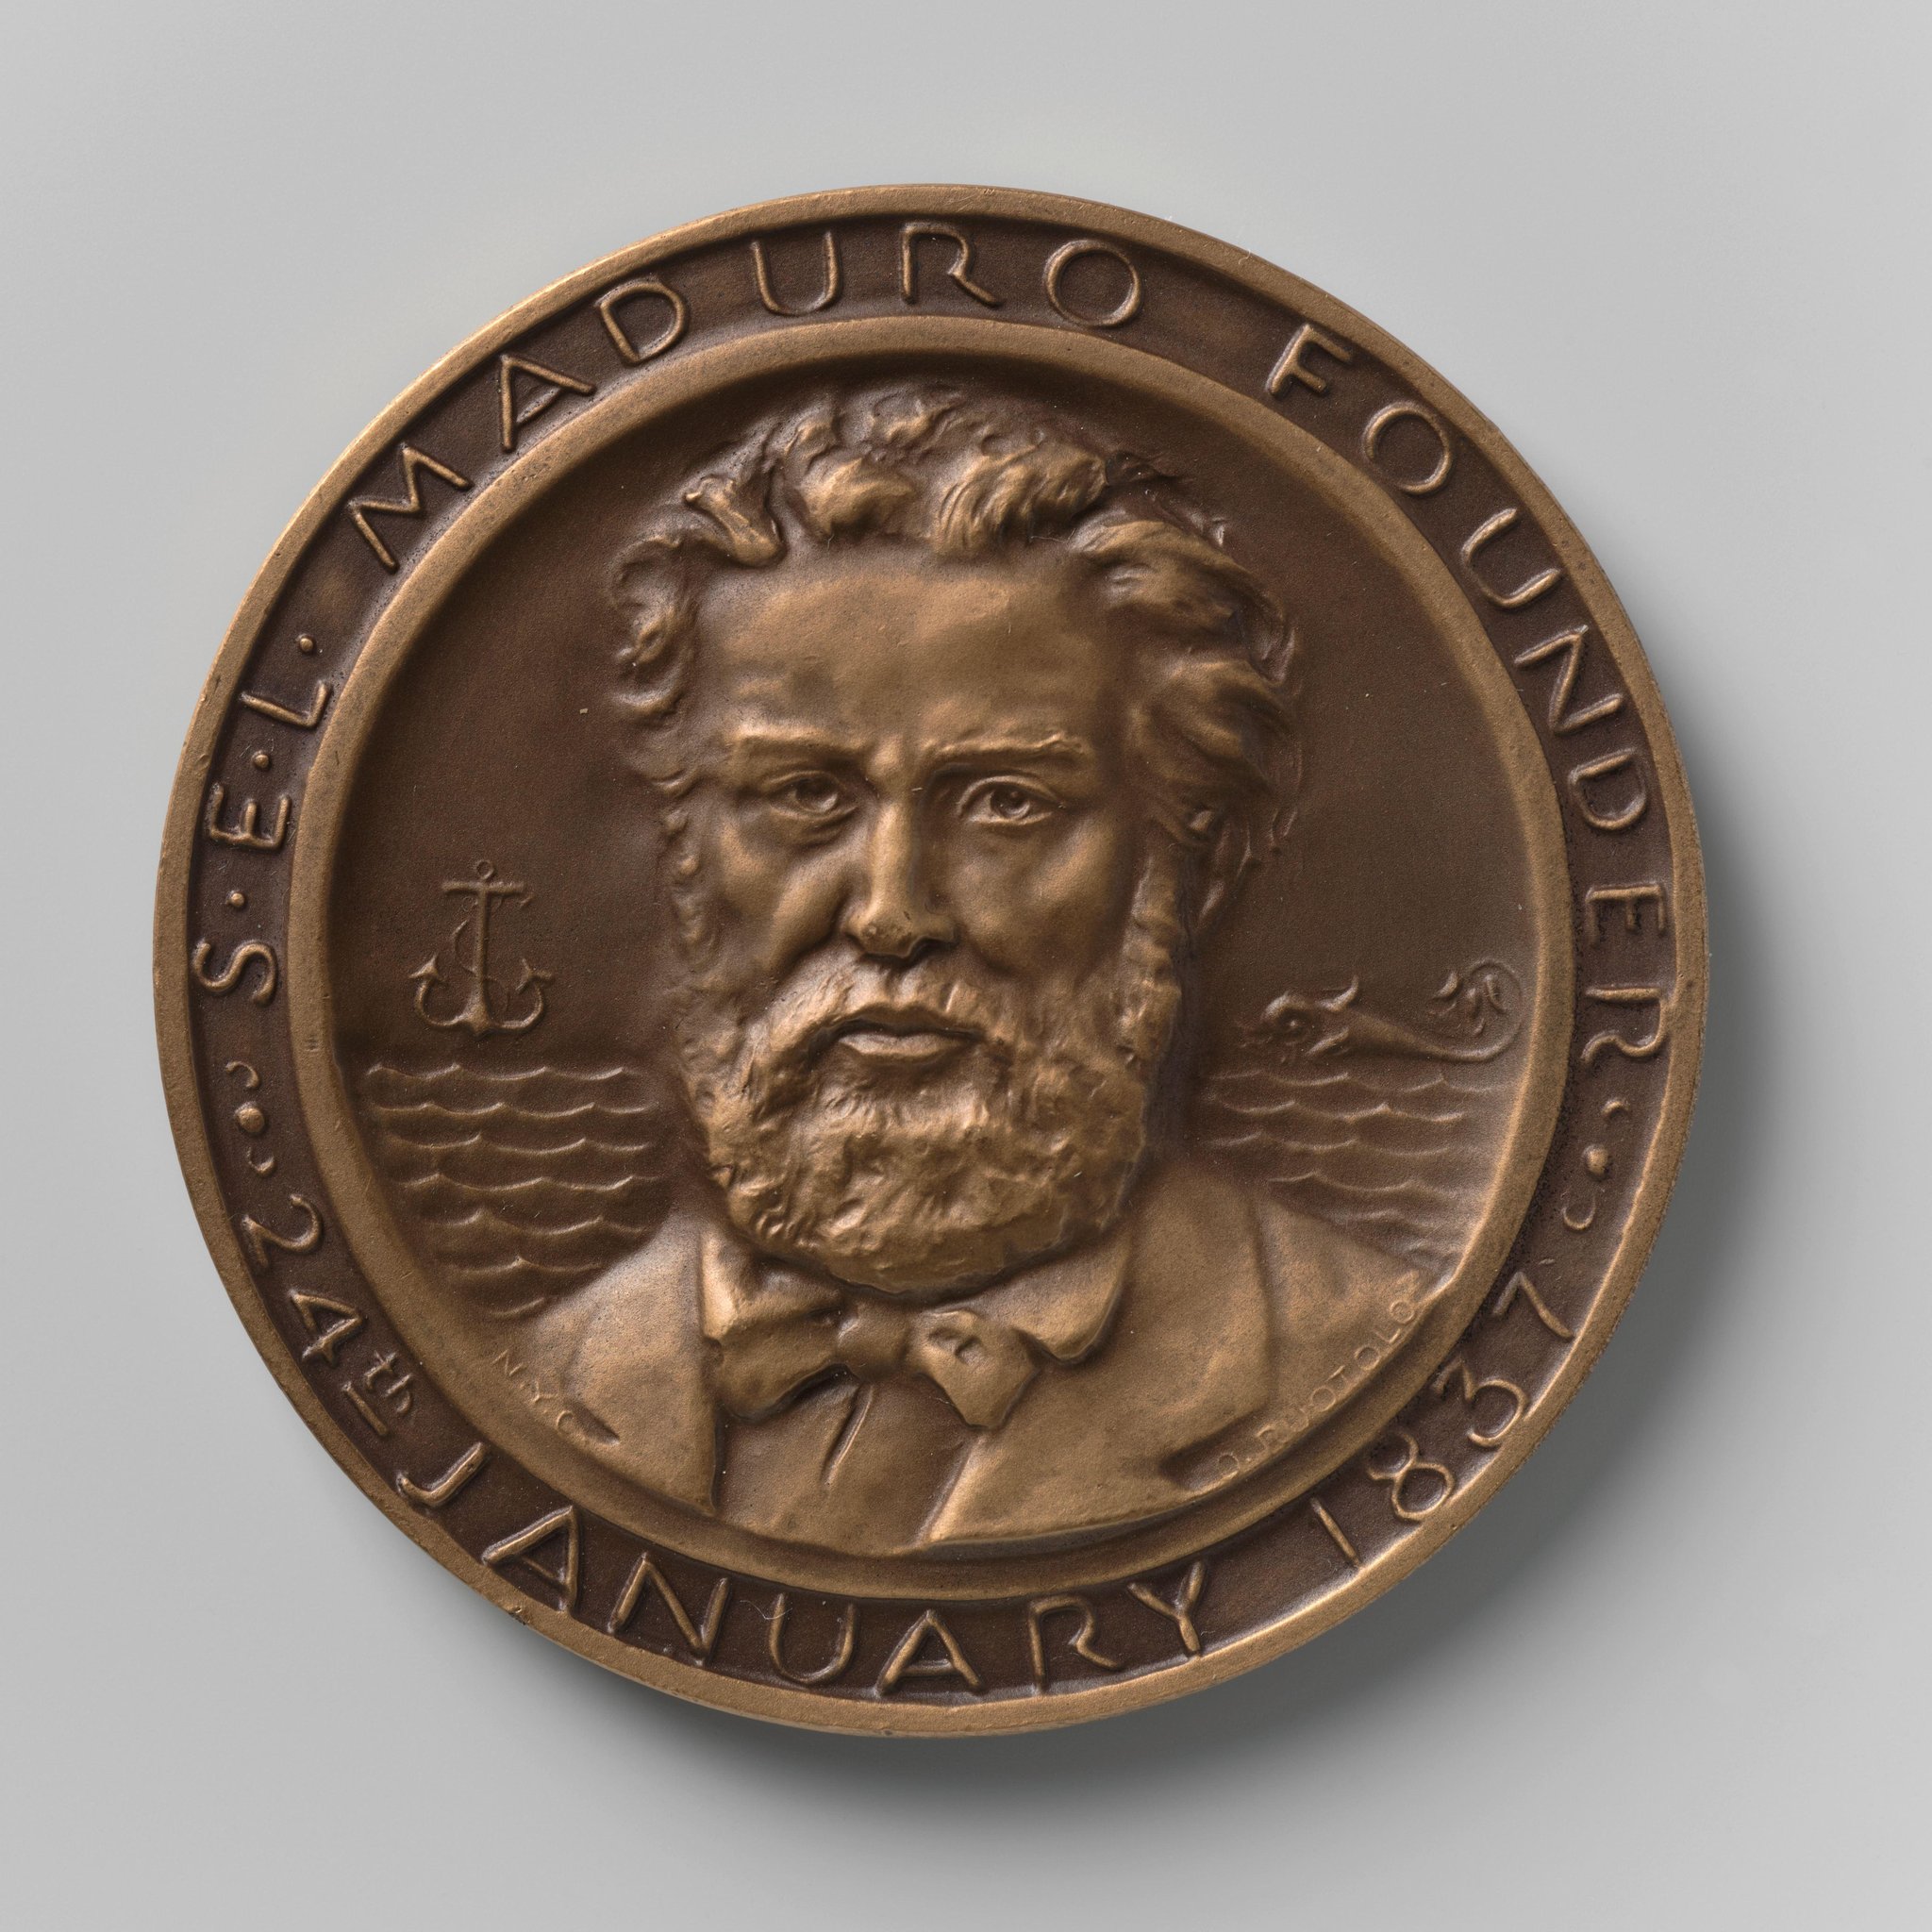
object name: history medal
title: Honderdjarig bestaan van de firma S.E.L. Maduro & Sons te Curaçao 1937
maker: onorio ruotolo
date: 1937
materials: bronze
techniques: striking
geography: new york city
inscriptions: factory mark: ‘MEDALLIC ART CO. N.V. BRONZE’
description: Bronzen penning, op de voorzijde het aanziende borstbeeld van S.E.L. Maduro waarachter de zee met een anker en een dolfijn, met omschrift, op de keerzijde Mercurius met een hoorn des overvloeds, links een Curaçaos gezin, op de achtergrond water met een schip en een huis, met omschrift, met verklaring.